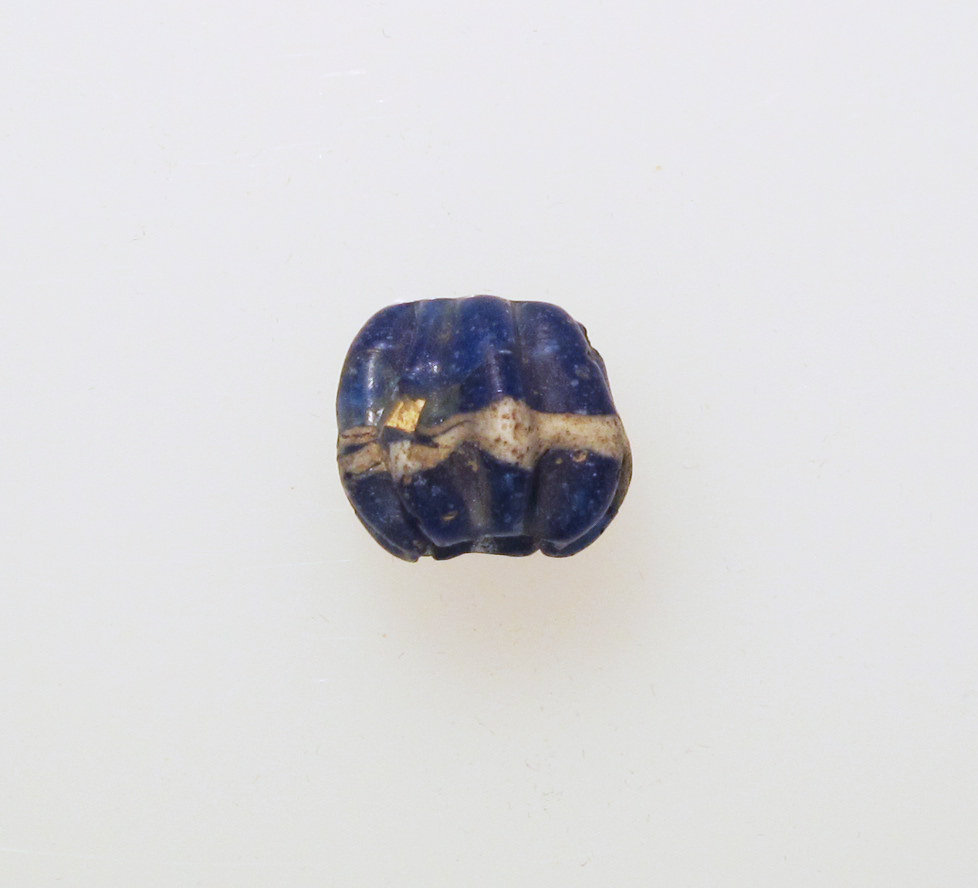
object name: bead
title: Glass bead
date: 7000 BCE-330 CE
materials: glass